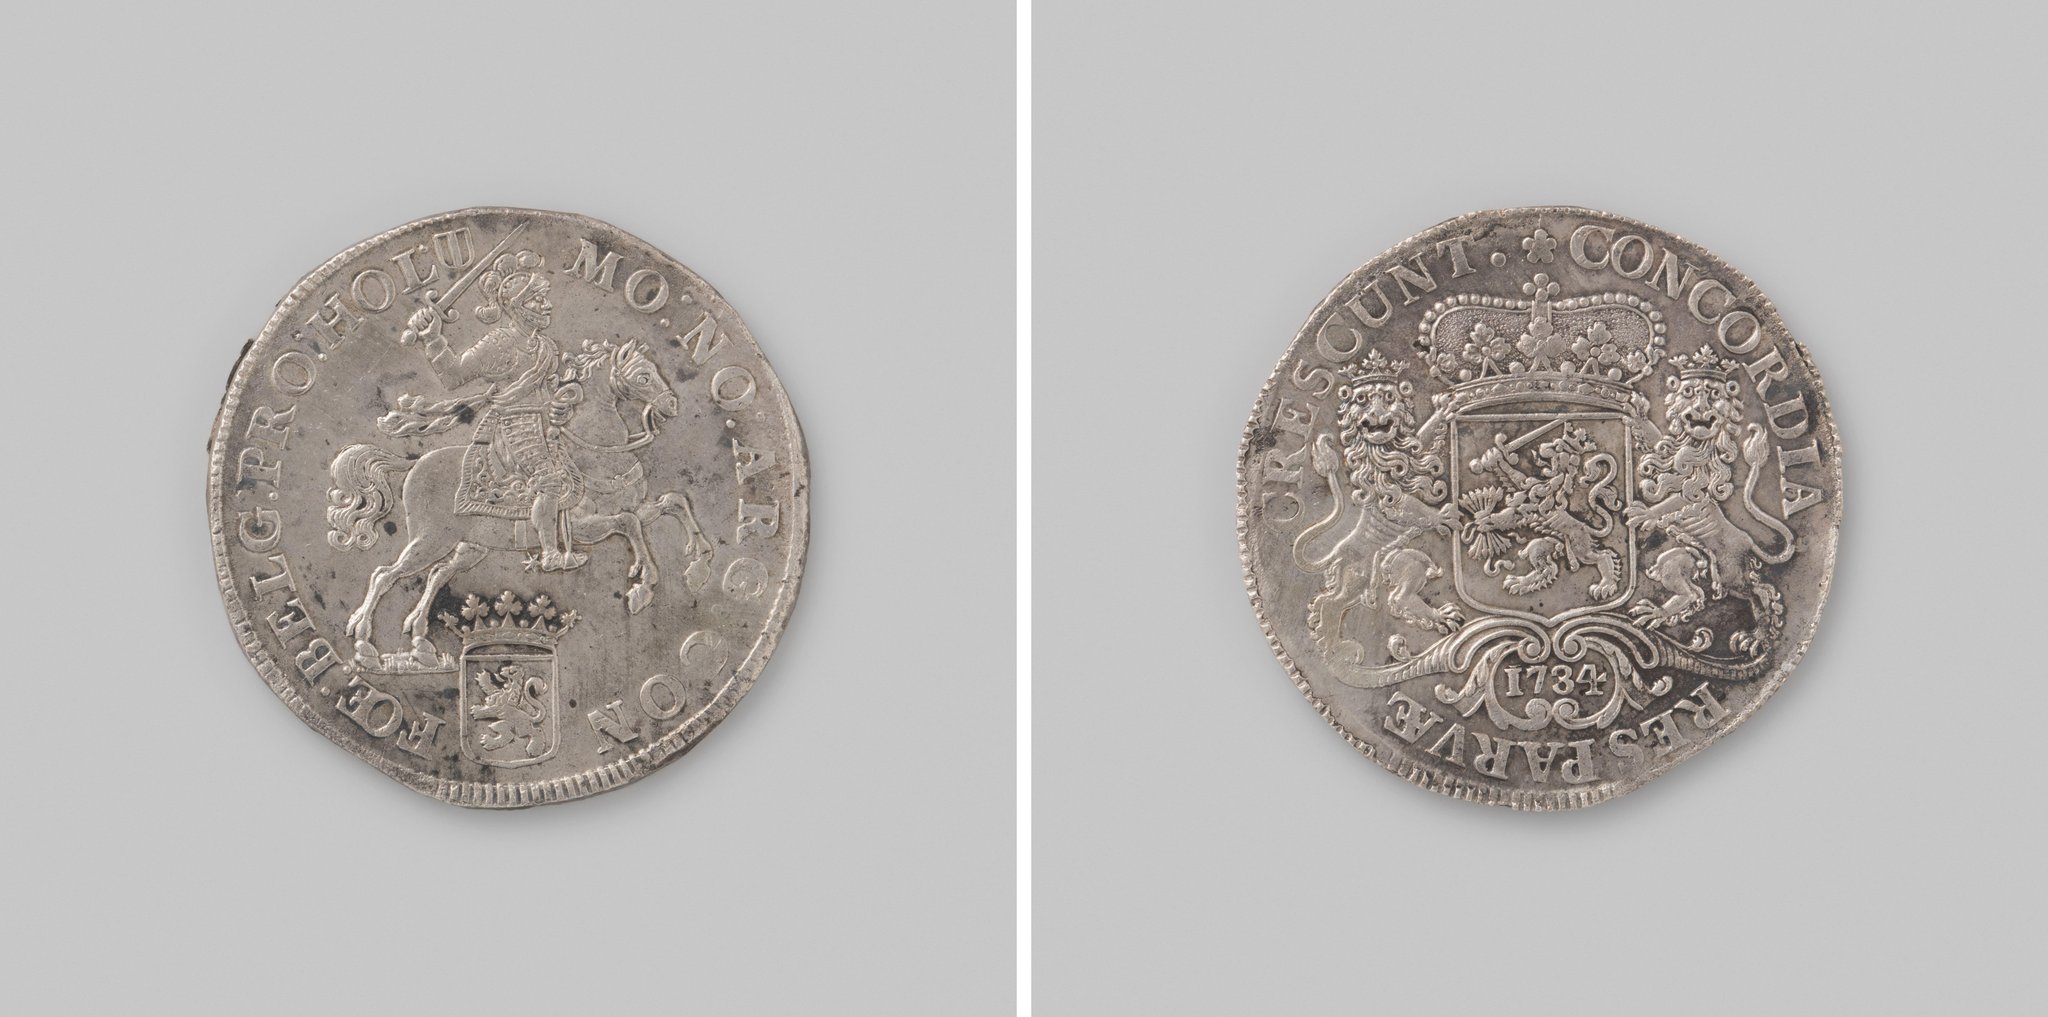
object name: coin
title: Ducaton afkomstig van het wrak van de Oost-Indiëvaarder 't Vliegend Hart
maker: Anonymous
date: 1729-1734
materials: silver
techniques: striking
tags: 't vliegend hart (schip)